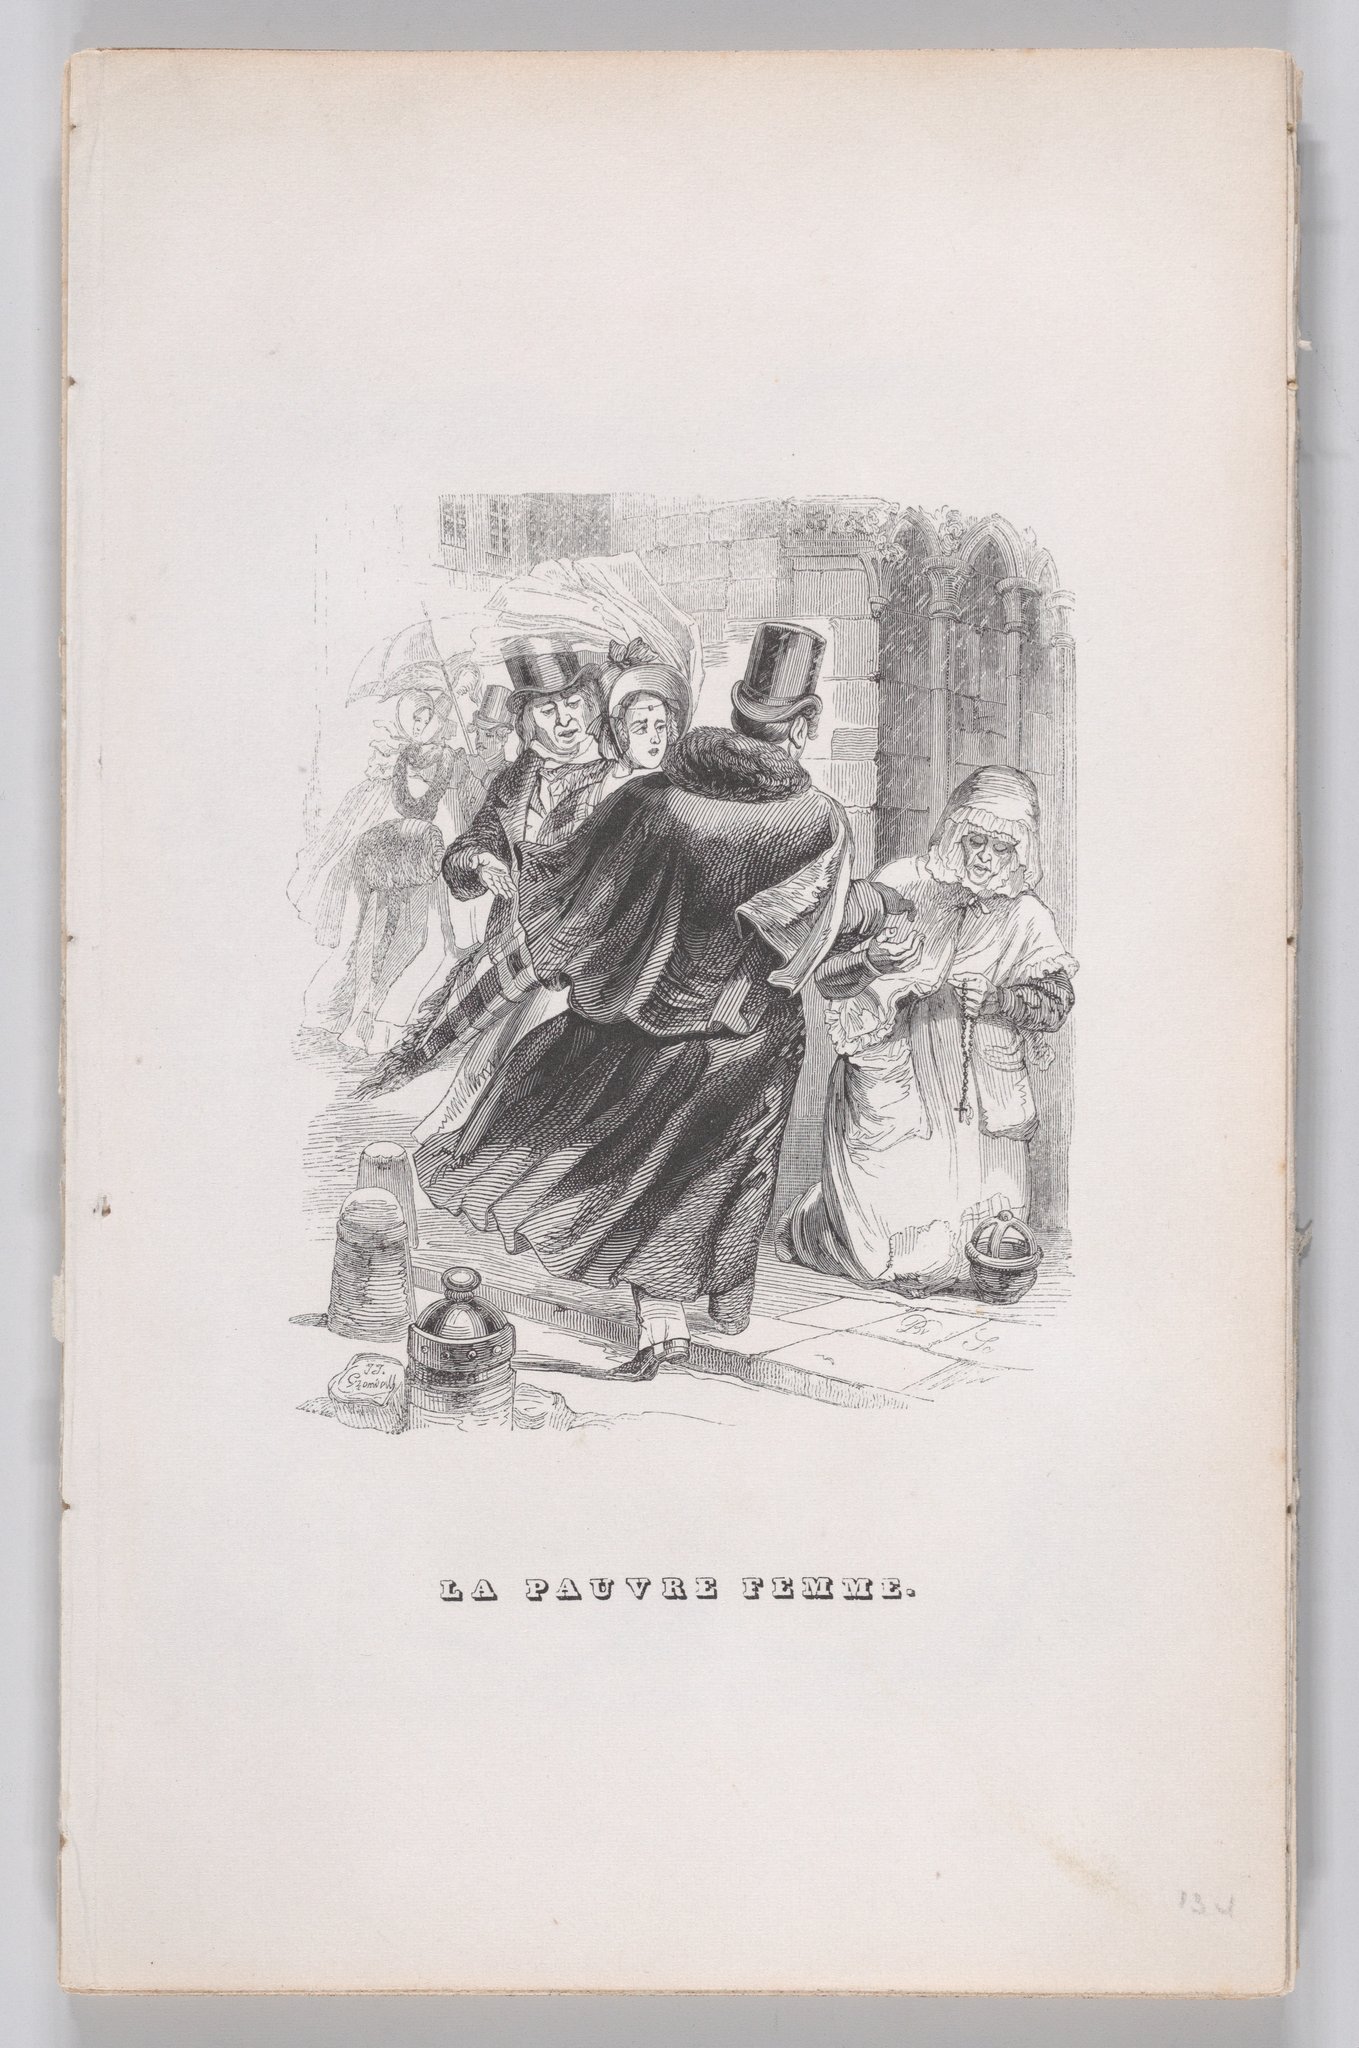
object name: print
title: The Poor Woman, from "The Complete Works of Béranger"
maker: j. j. grandville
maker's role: illustrator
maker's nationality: french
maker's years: 1803-1847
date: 1836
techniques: engraving